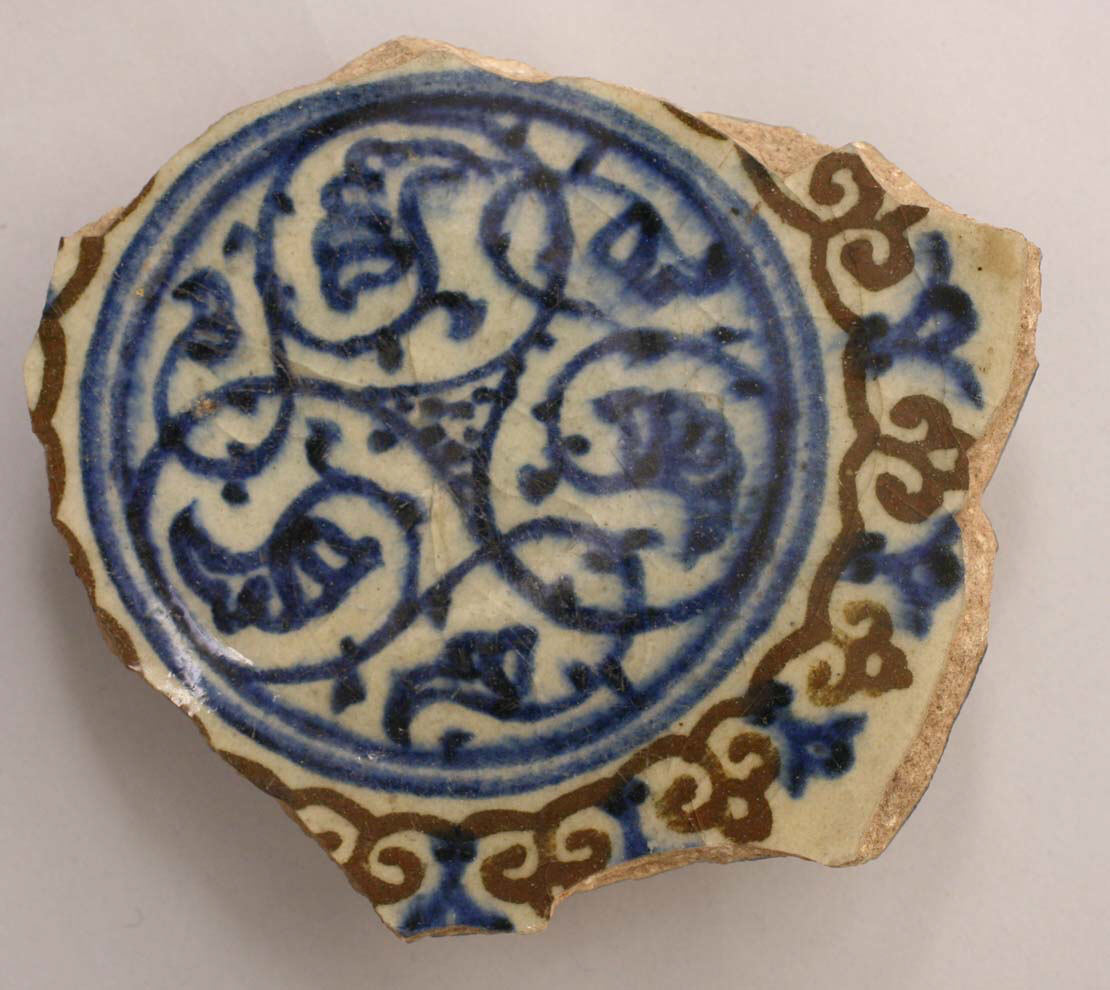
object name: fragment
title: Fragment of a Bowl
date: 1201-1400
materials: glaze, stonepaste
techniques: underglaze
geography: syria